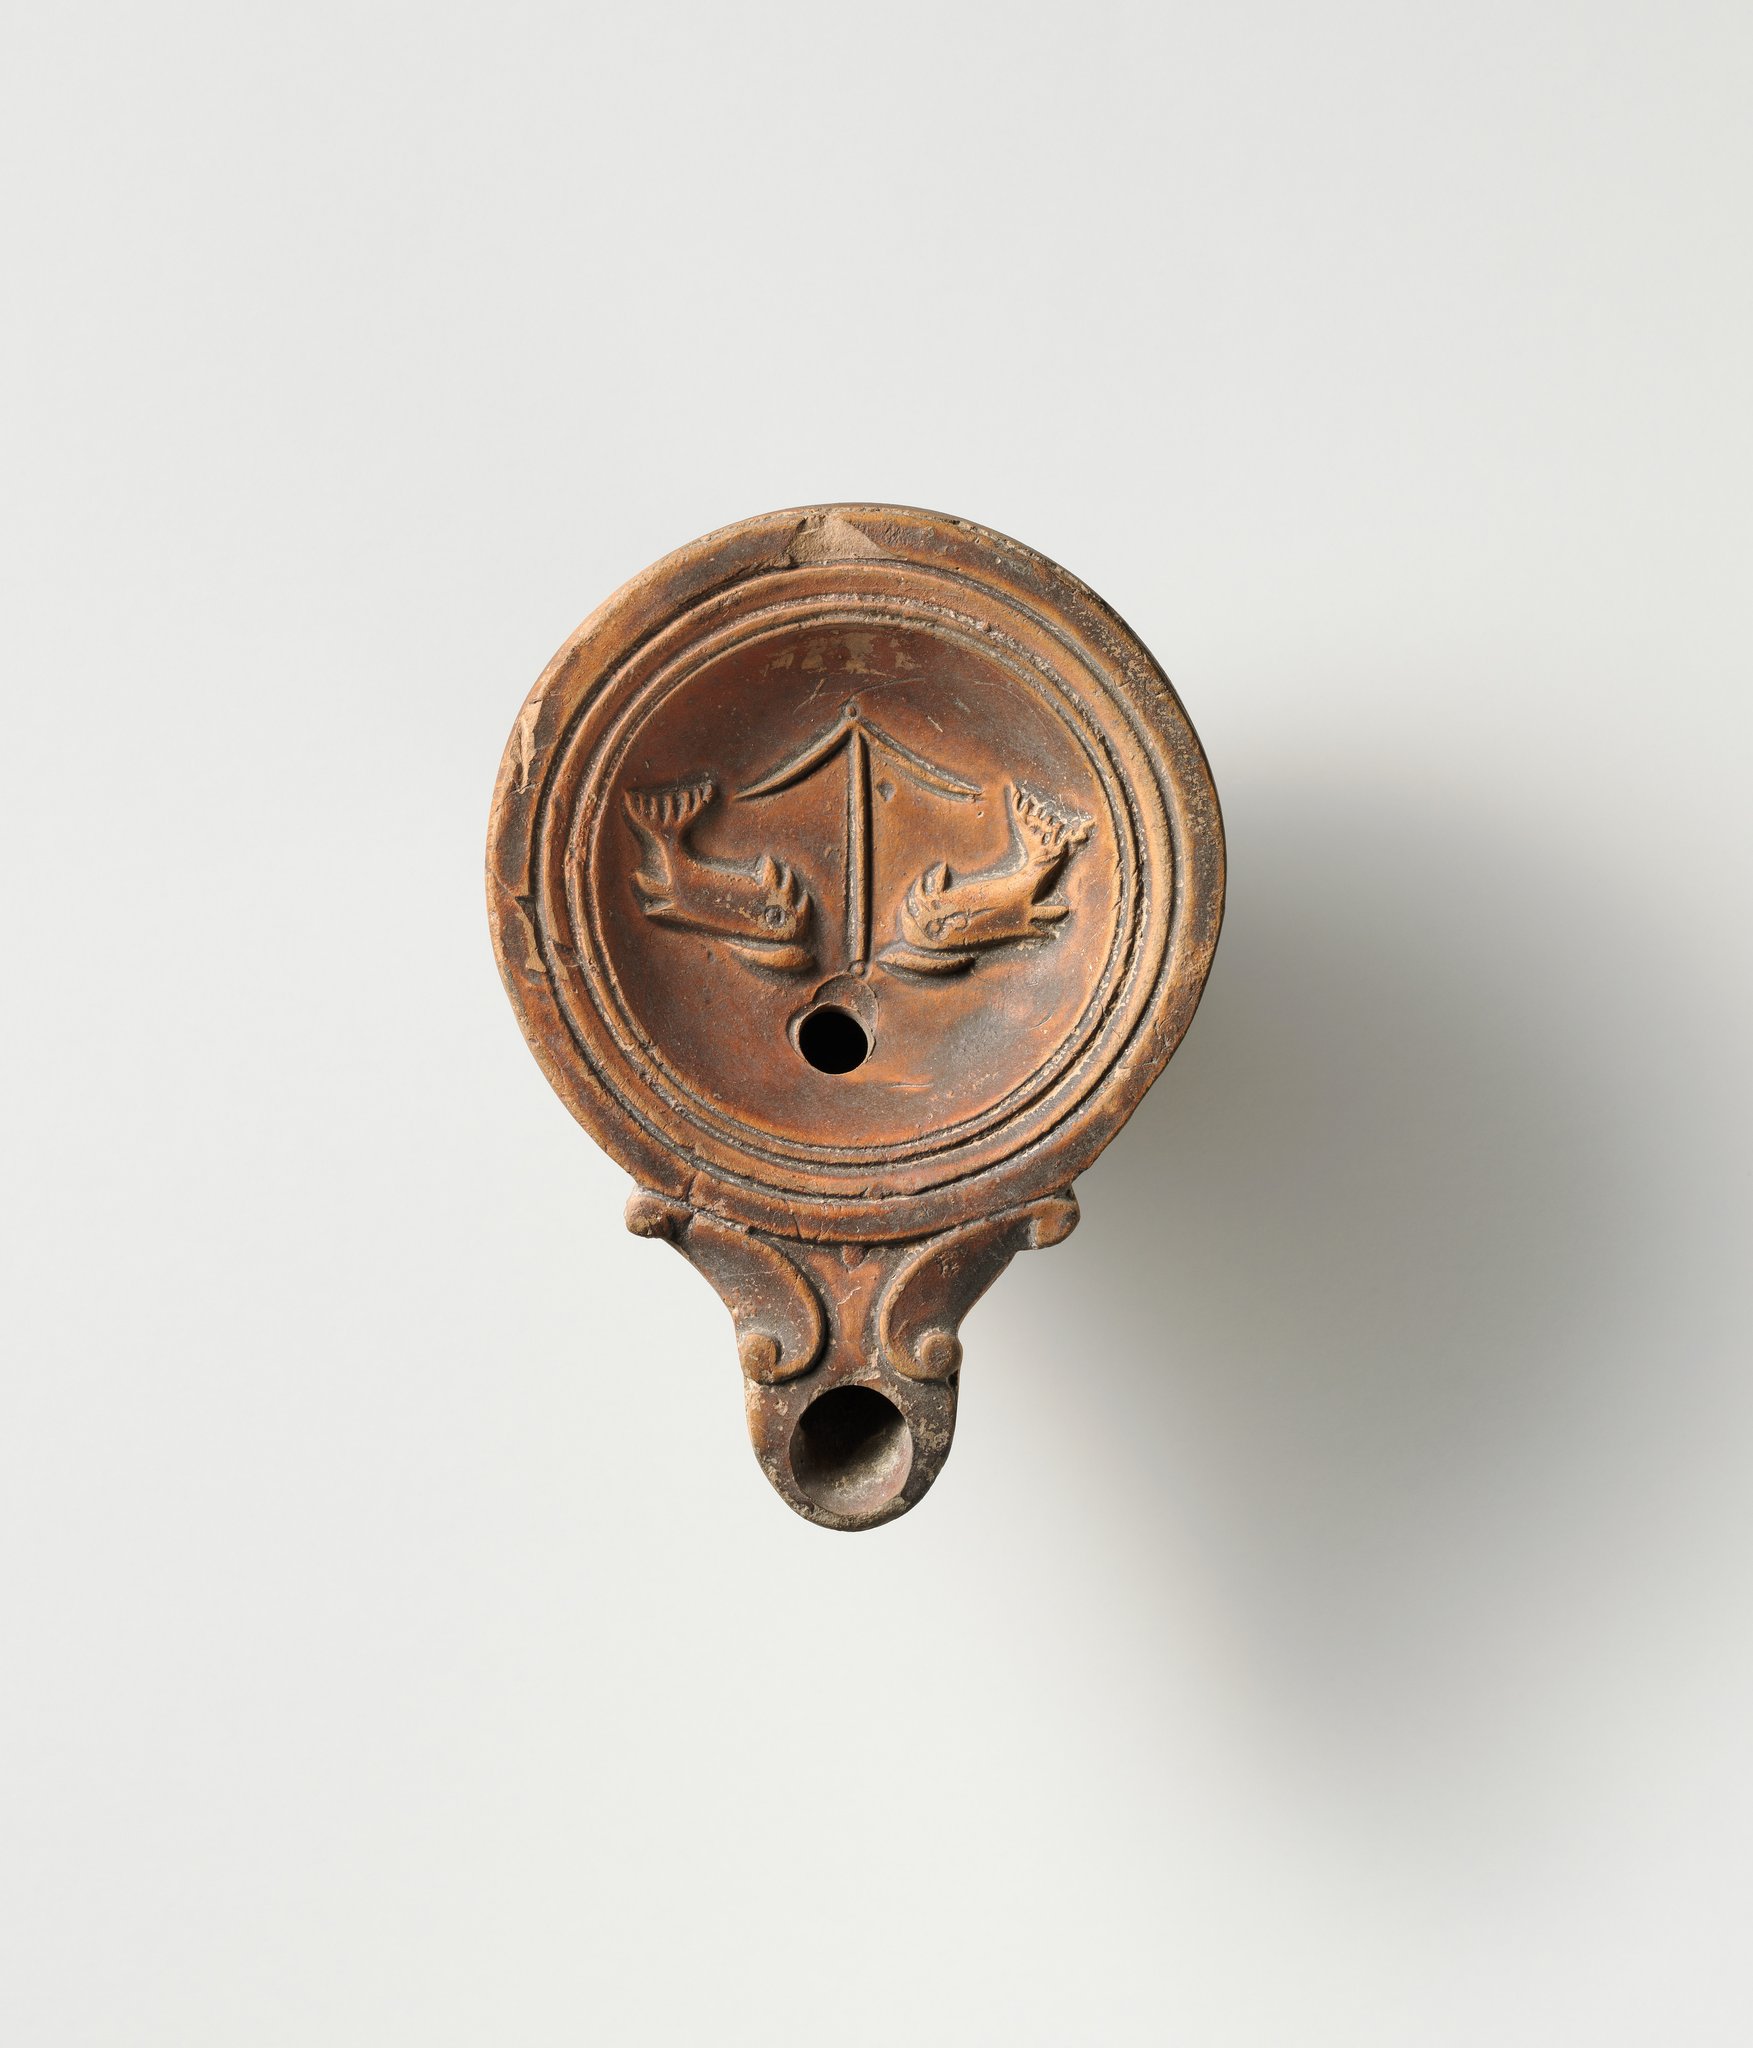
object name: lamp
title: Terracotta oil lamp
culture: roman, cypriot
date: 40-100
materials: terracotta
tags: dolphins